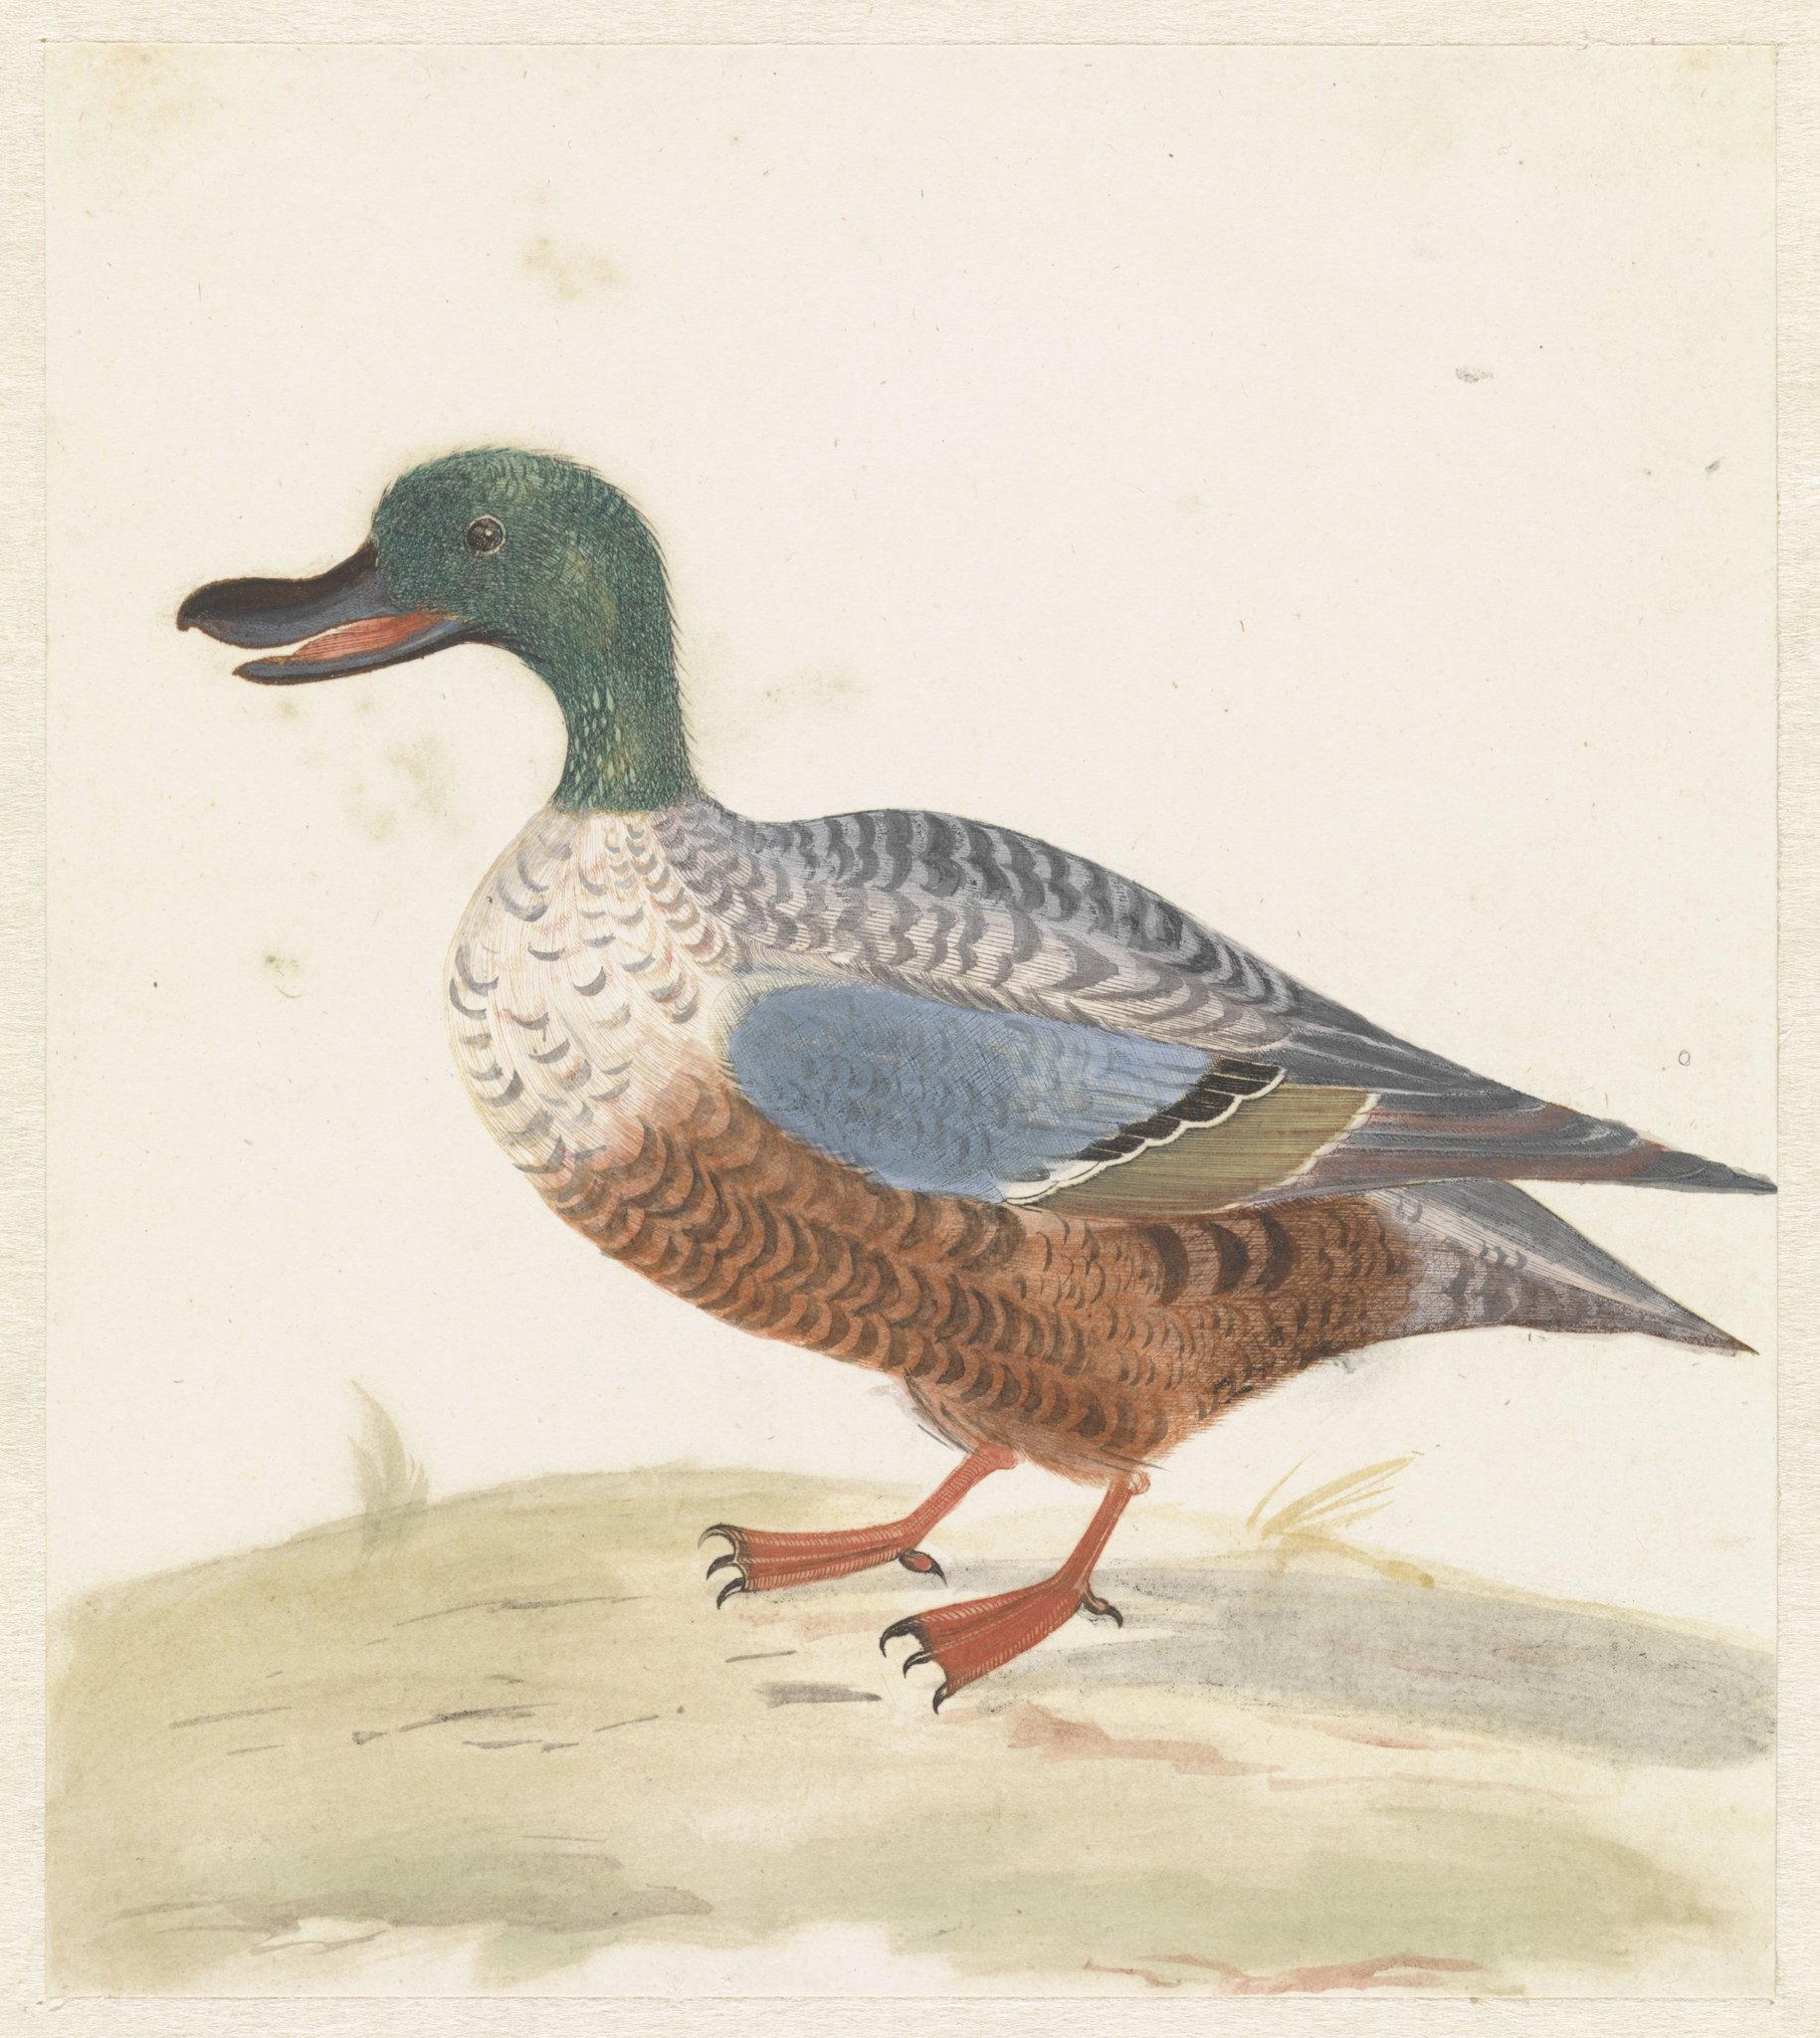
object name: print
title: Staande slobeend naar links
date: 1688-1698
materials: paper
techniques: printing, engraving, hand coloring, lithography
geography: netherlands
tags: water-birds: duck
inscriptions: collector's mark: Lugt 2228, collector's mark: Lugt 2760